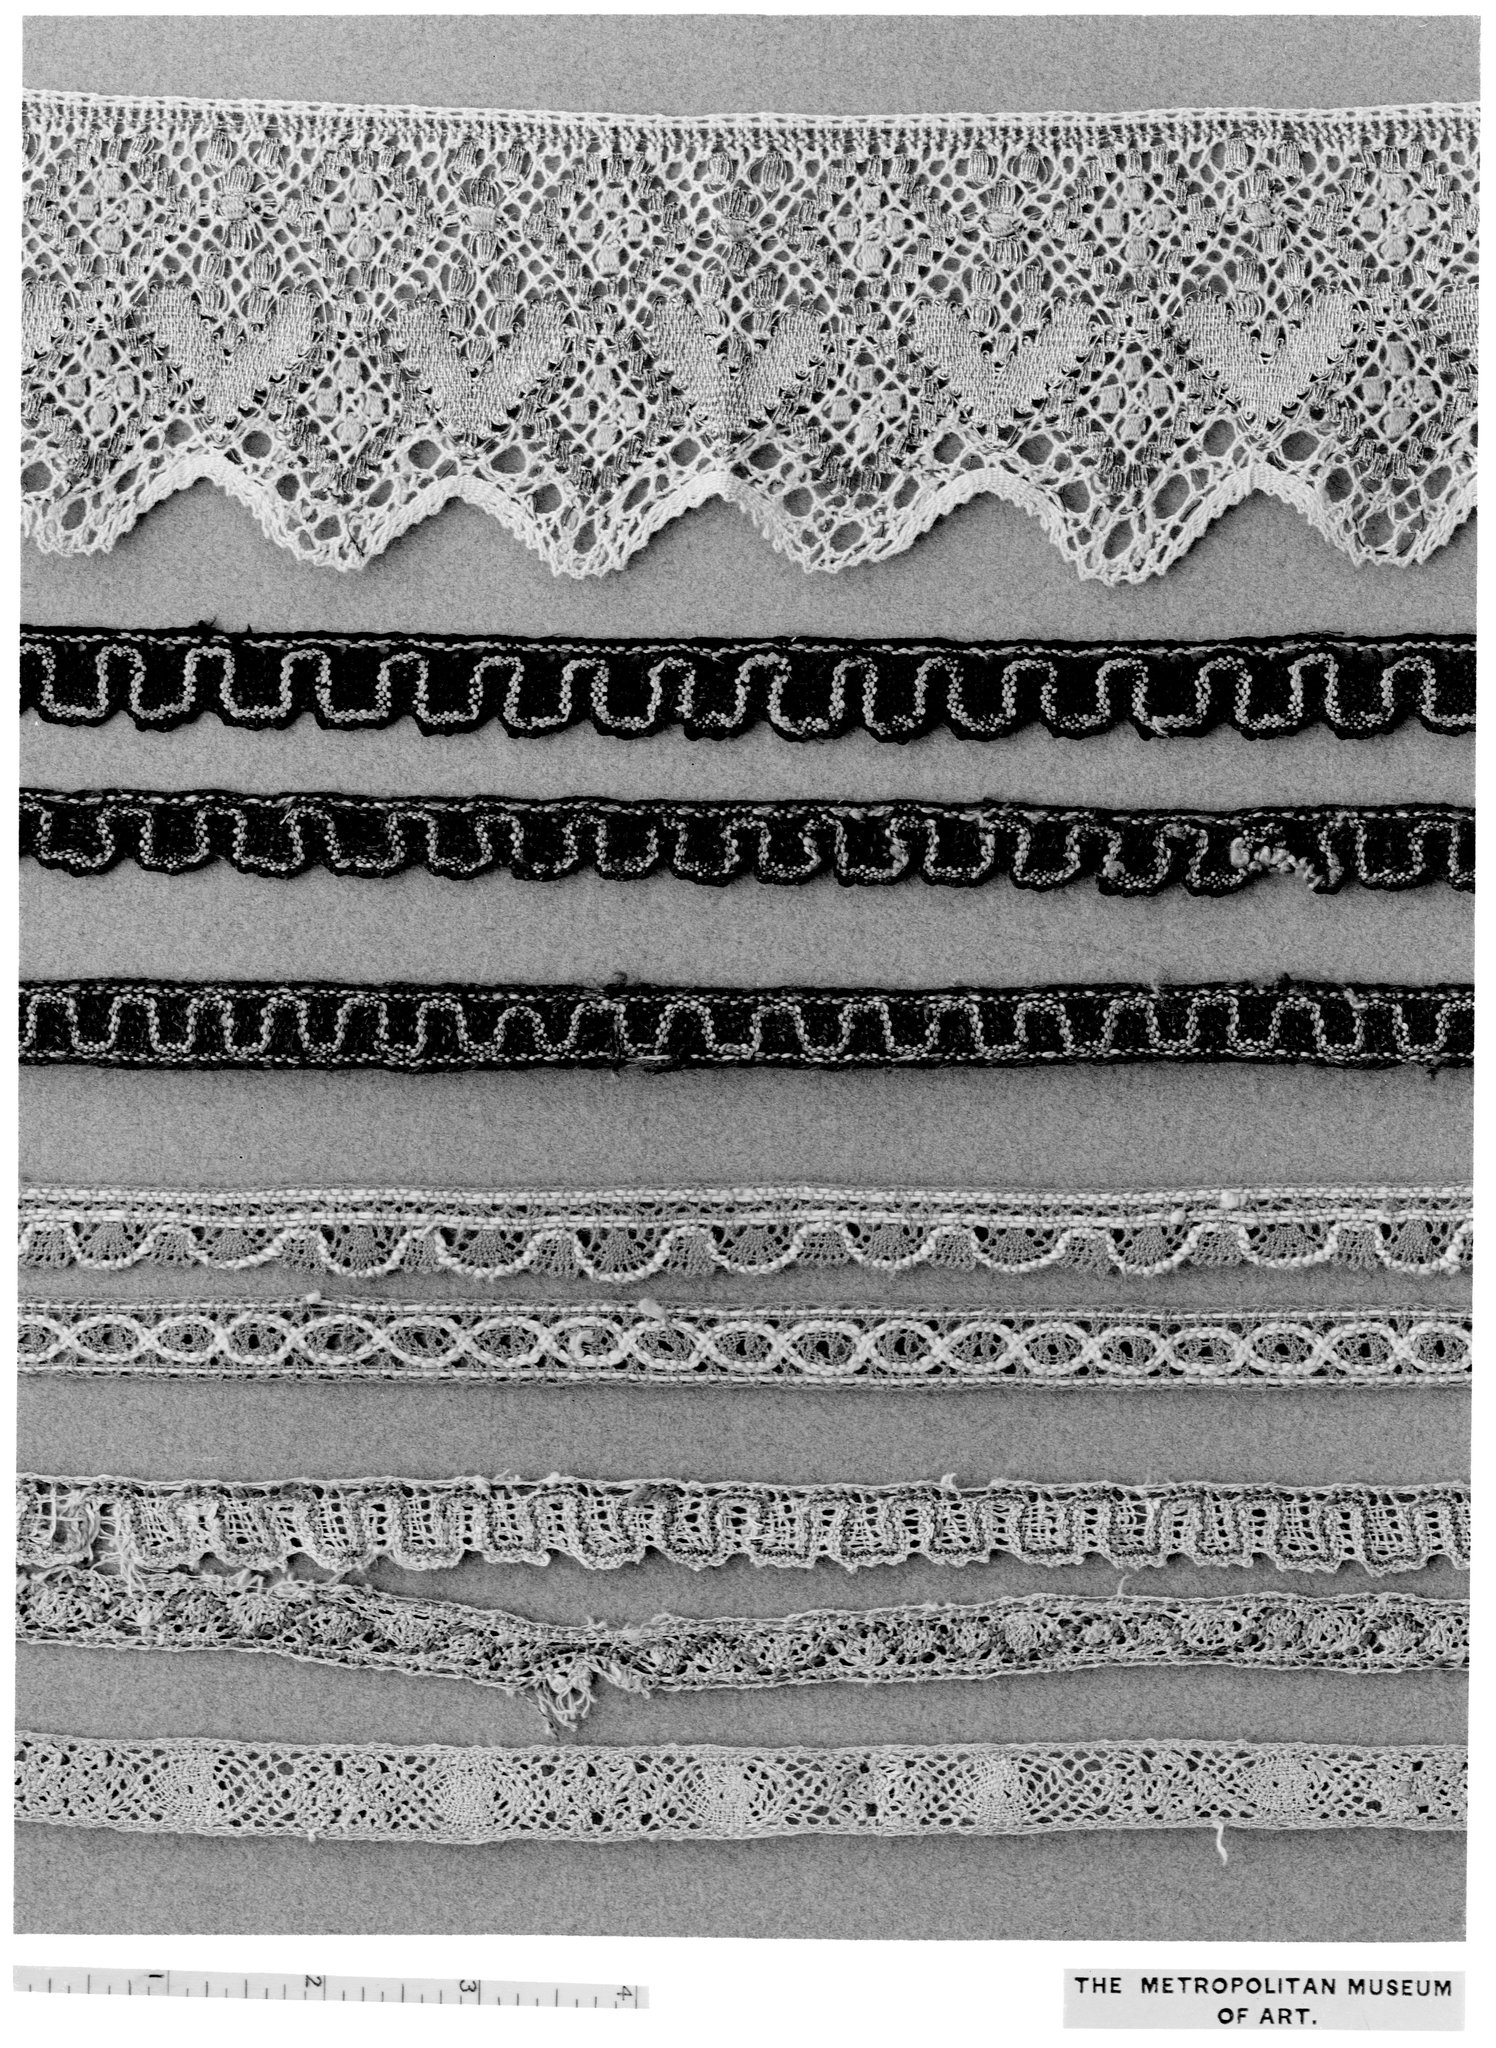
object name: edging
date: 1801-1900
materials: cotton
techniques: lace